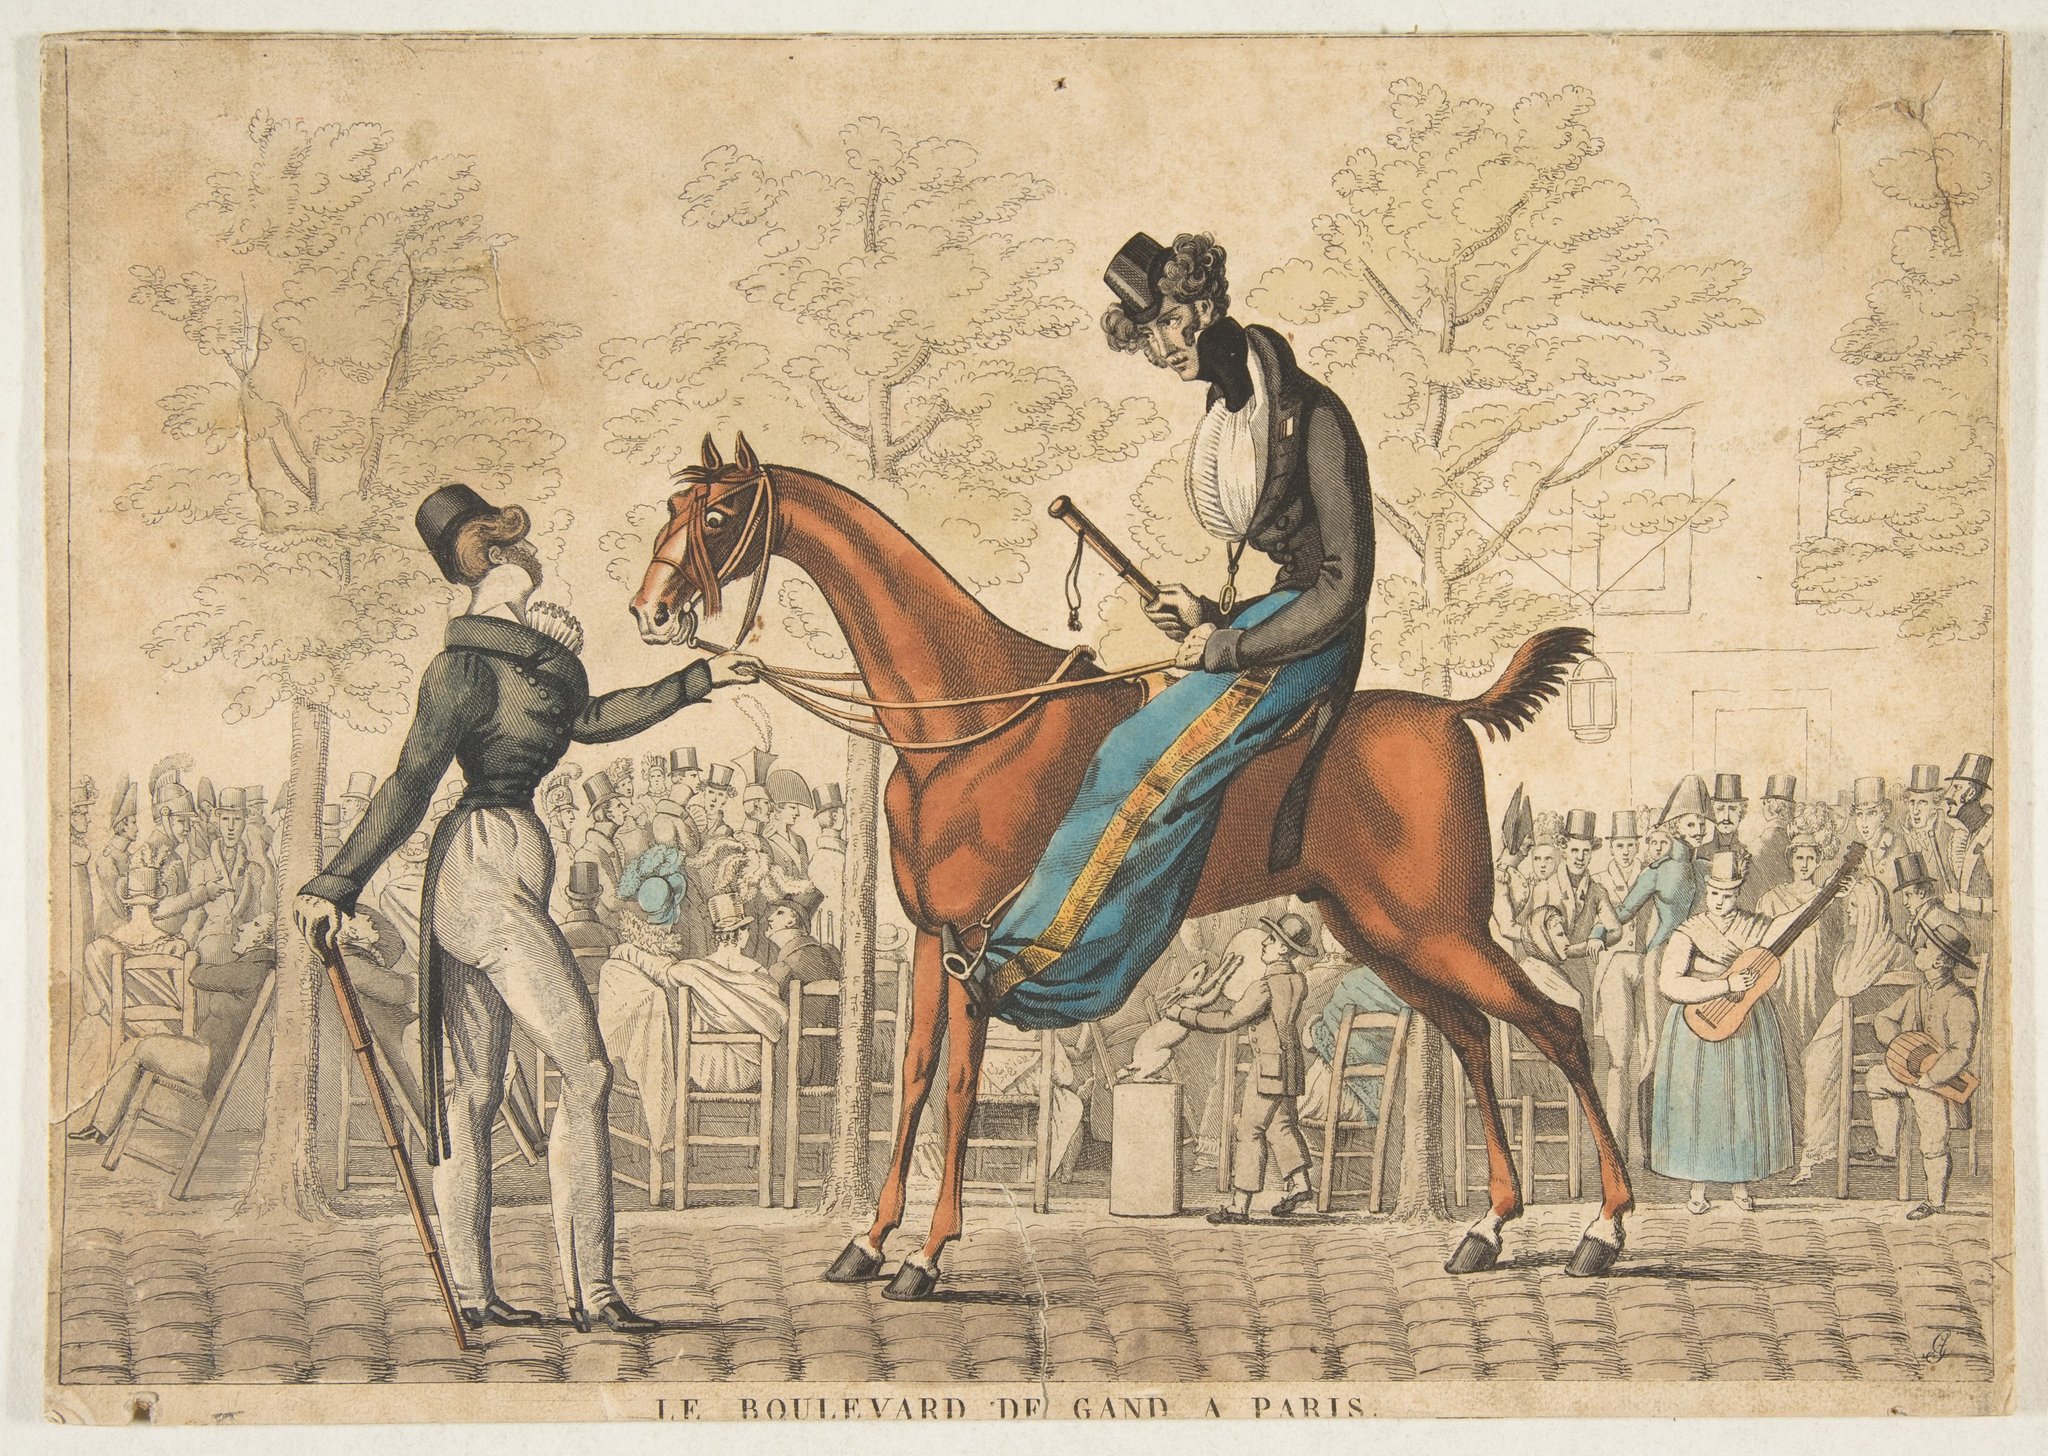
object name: print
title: Le Boulevard de Gand à Paris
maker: georges jacques gatine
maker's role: artist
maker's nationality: french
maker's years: 1773-1824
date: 1801-1900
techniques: etching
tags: men,women,horses,caricature